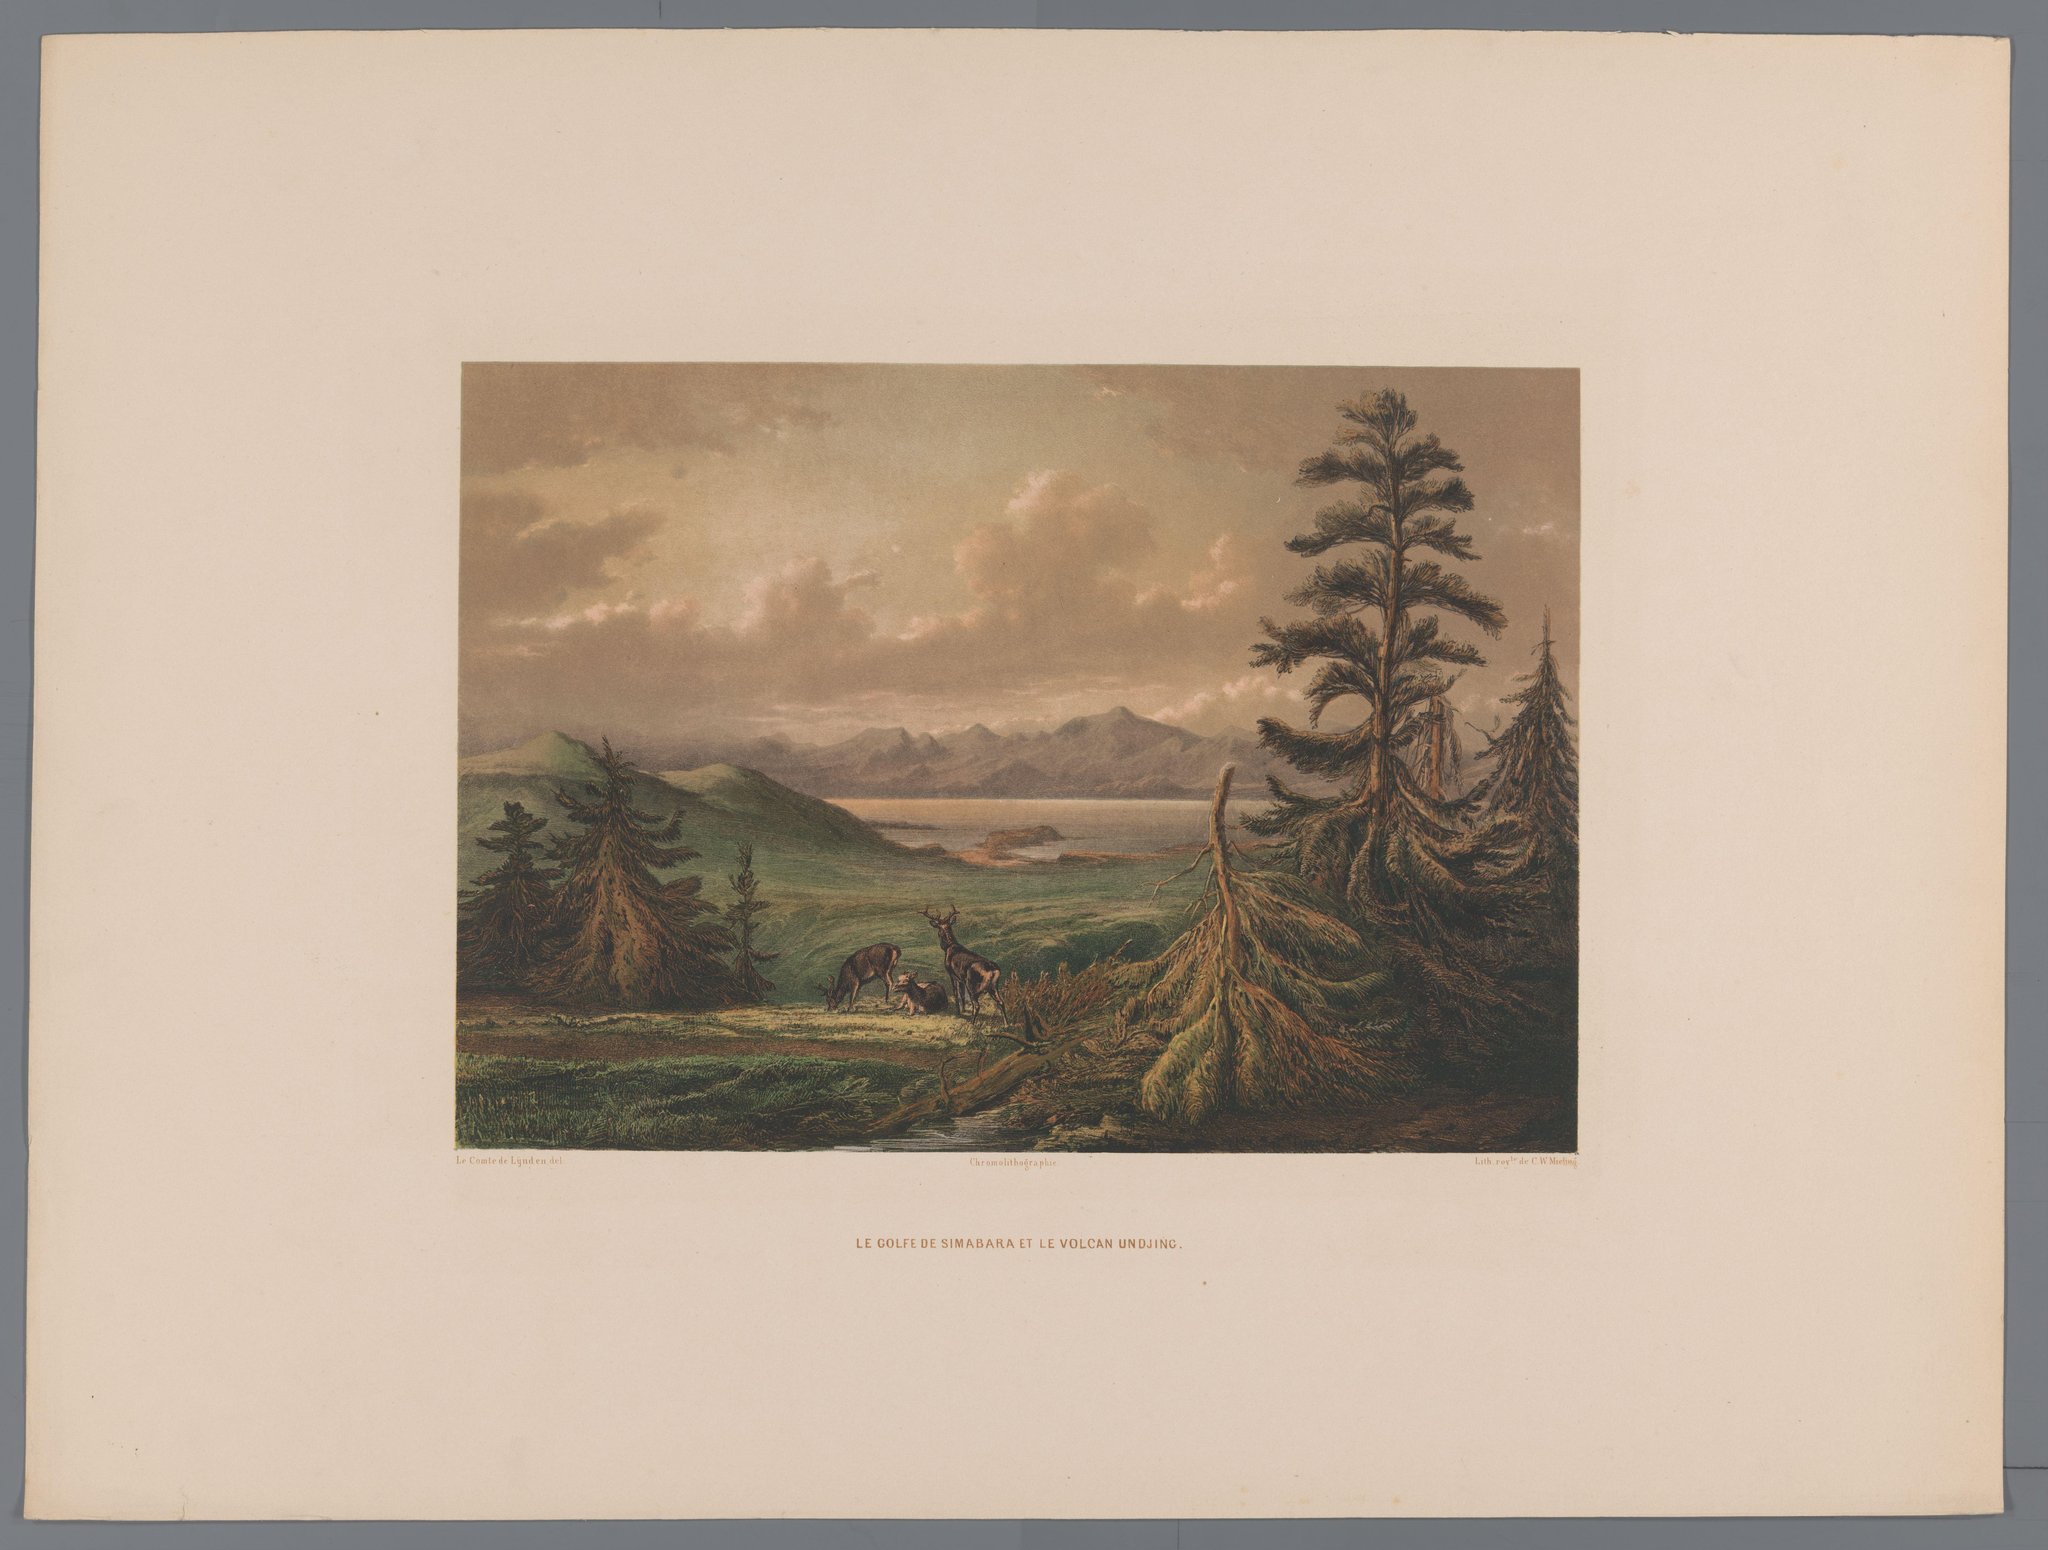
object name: print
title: Landschap met op de achtergrond de baai van Shimabara en de vulkaan Unzen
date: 1862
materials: paper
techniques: chromolithography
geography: the hague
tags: hoofed animals: deer, volcano, japan